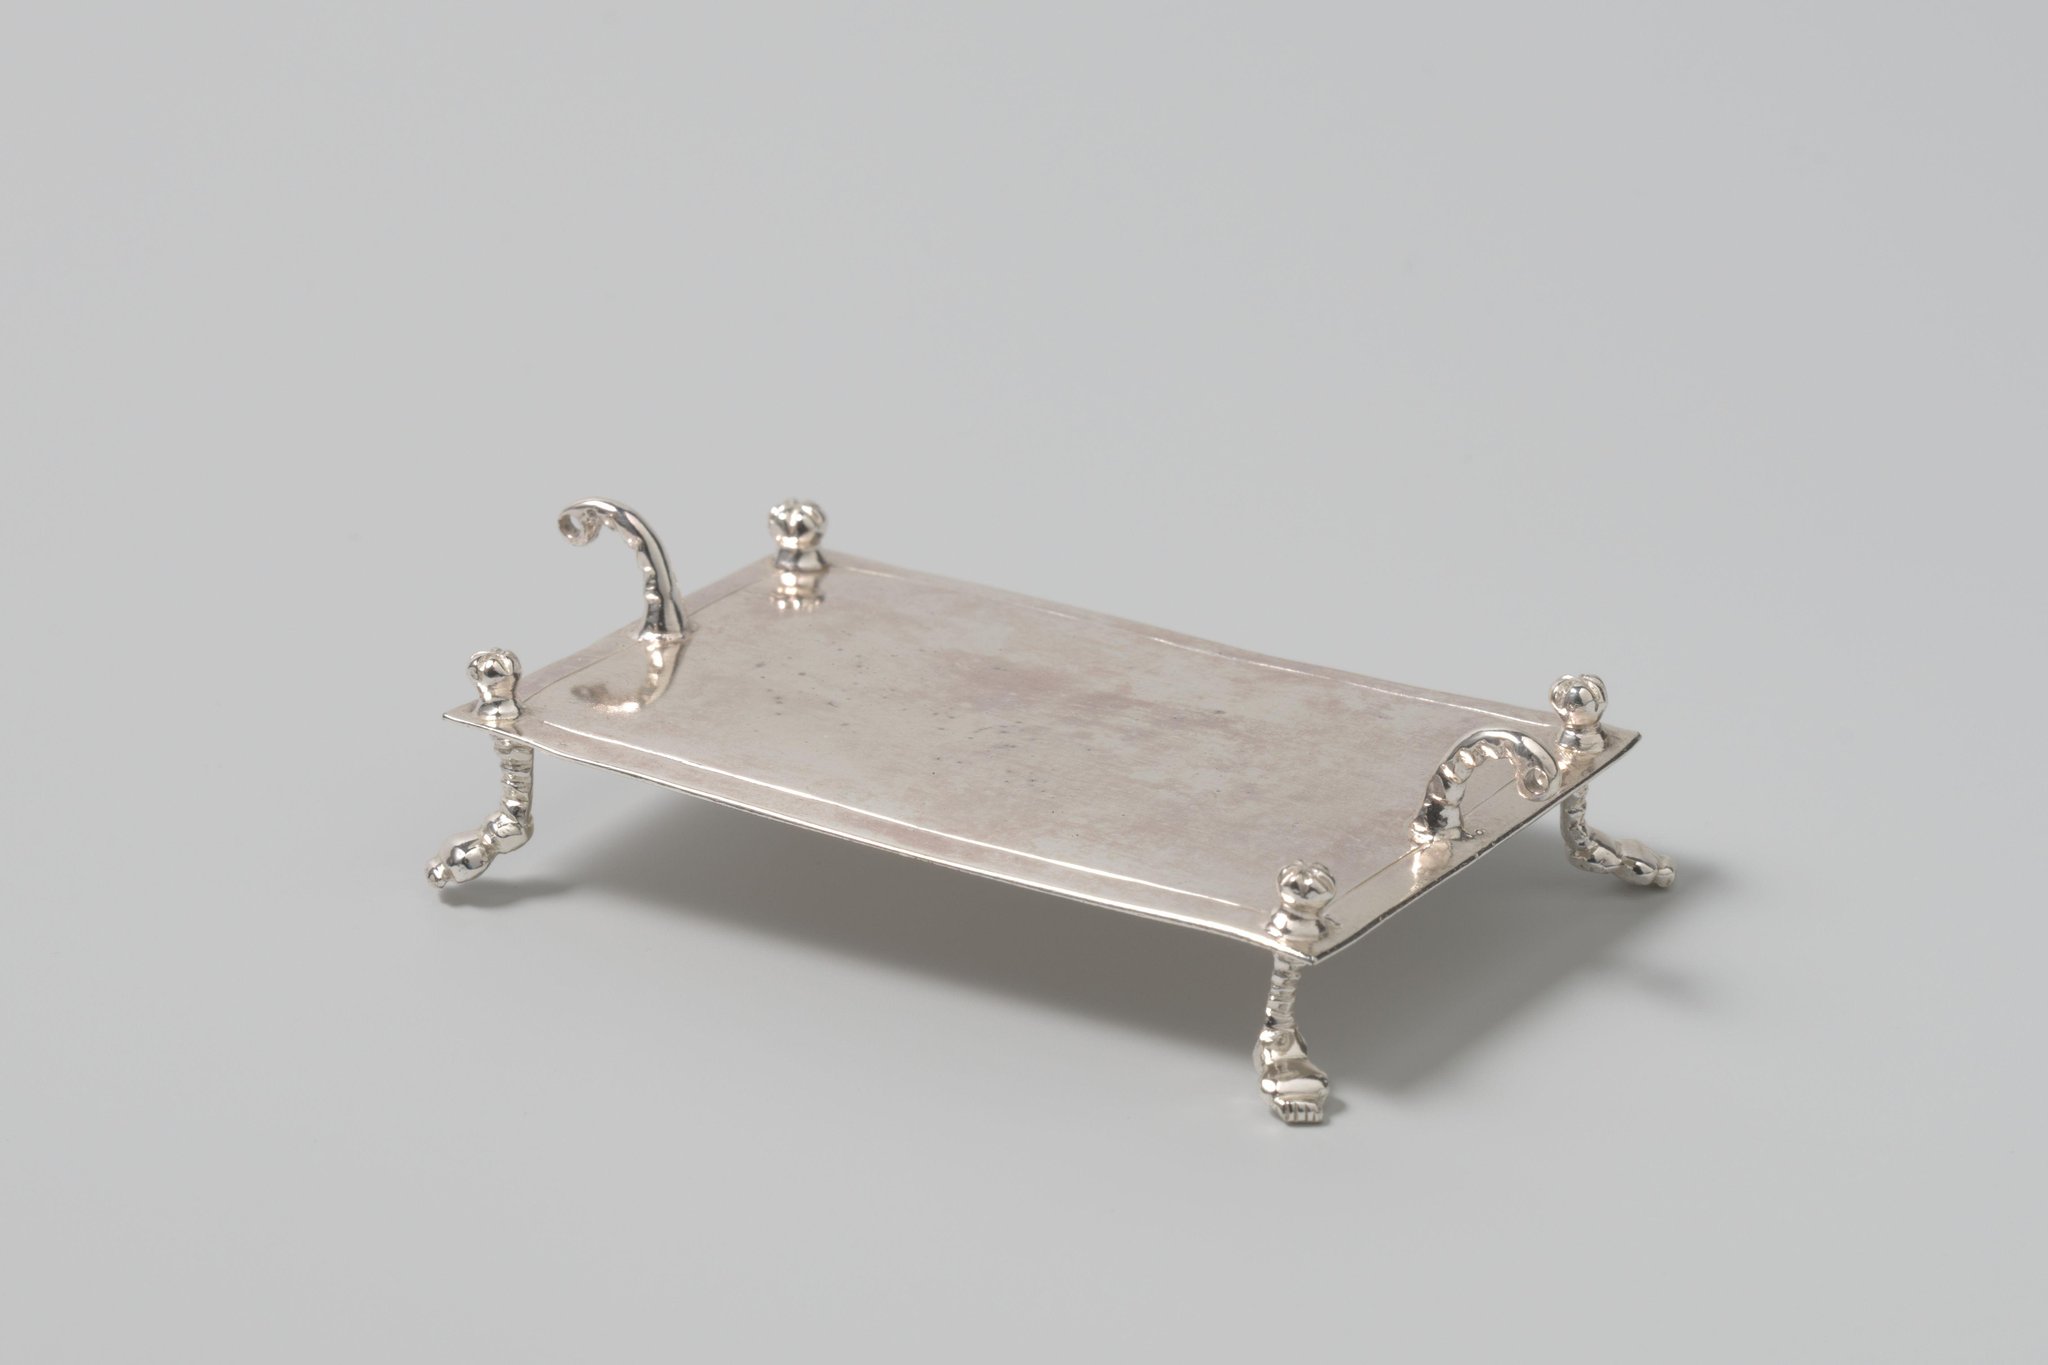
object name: fireback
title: Haardbodemplaat van zilver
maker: michiel maenbeeck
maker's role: silversmith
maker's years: 1634-1682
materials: silver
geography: haarlem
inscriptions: maker's mark: ‘wassende maan (Citroen 1975, nr. 1166)’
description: Haardbodemplaat van zilver op vier gebogen, geribbelde poten, gladde plaat met groefrand, vierknoppen op de hoeken en twee gebogen knoppen met een gat (waarin oorspronkelijk twee handvatten hingen).